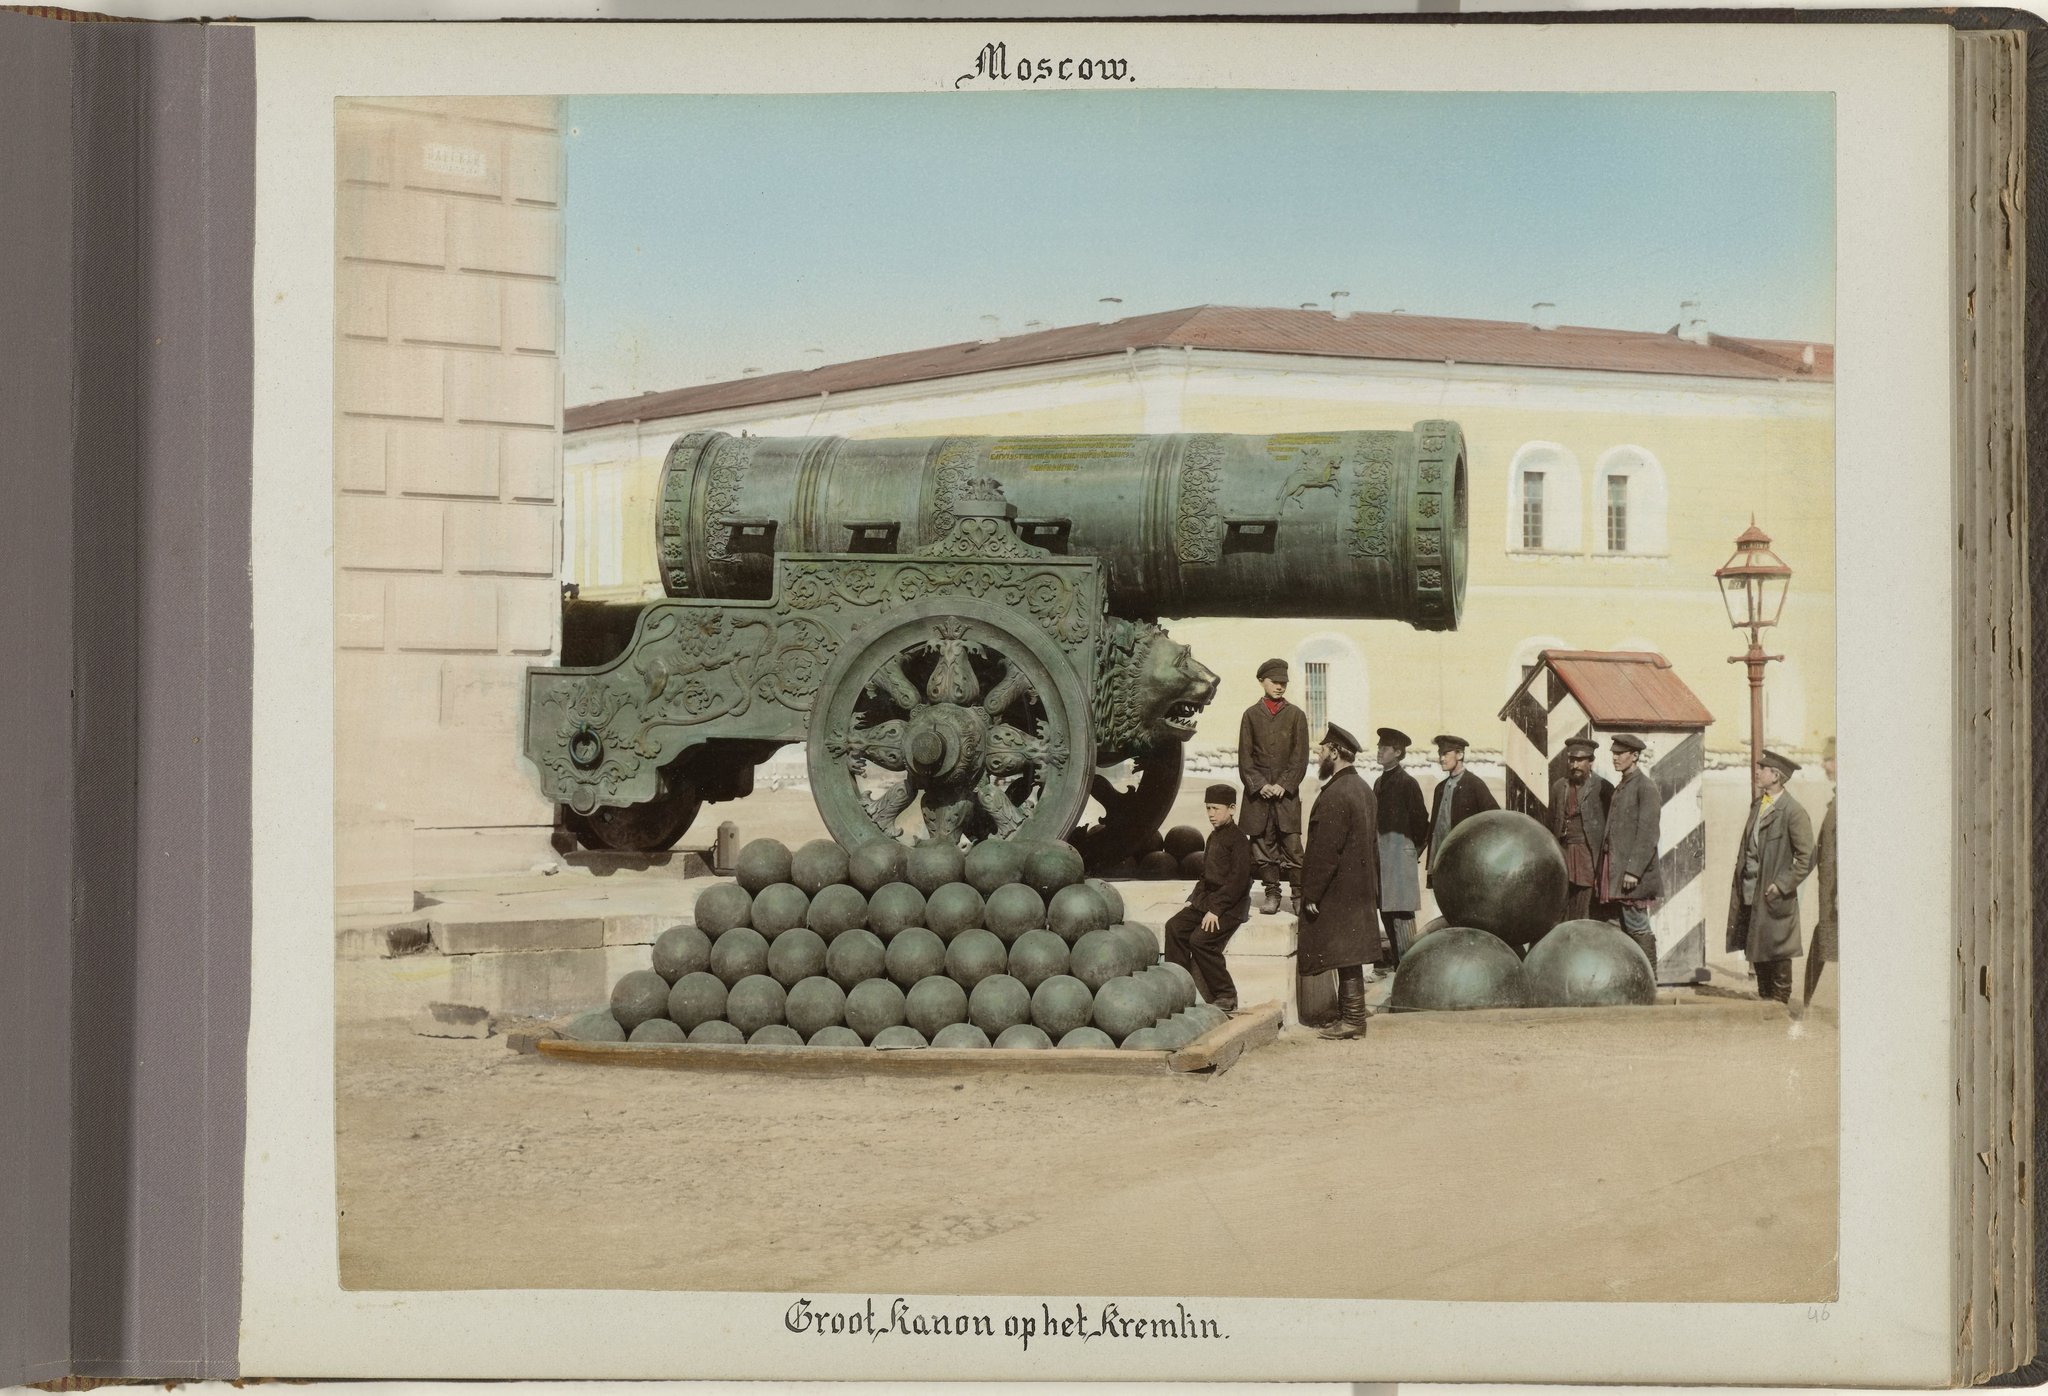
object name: photograph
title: Moscow, groot kanon op het Kremlin.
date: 1898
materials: paper, photographic support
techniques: albumen print